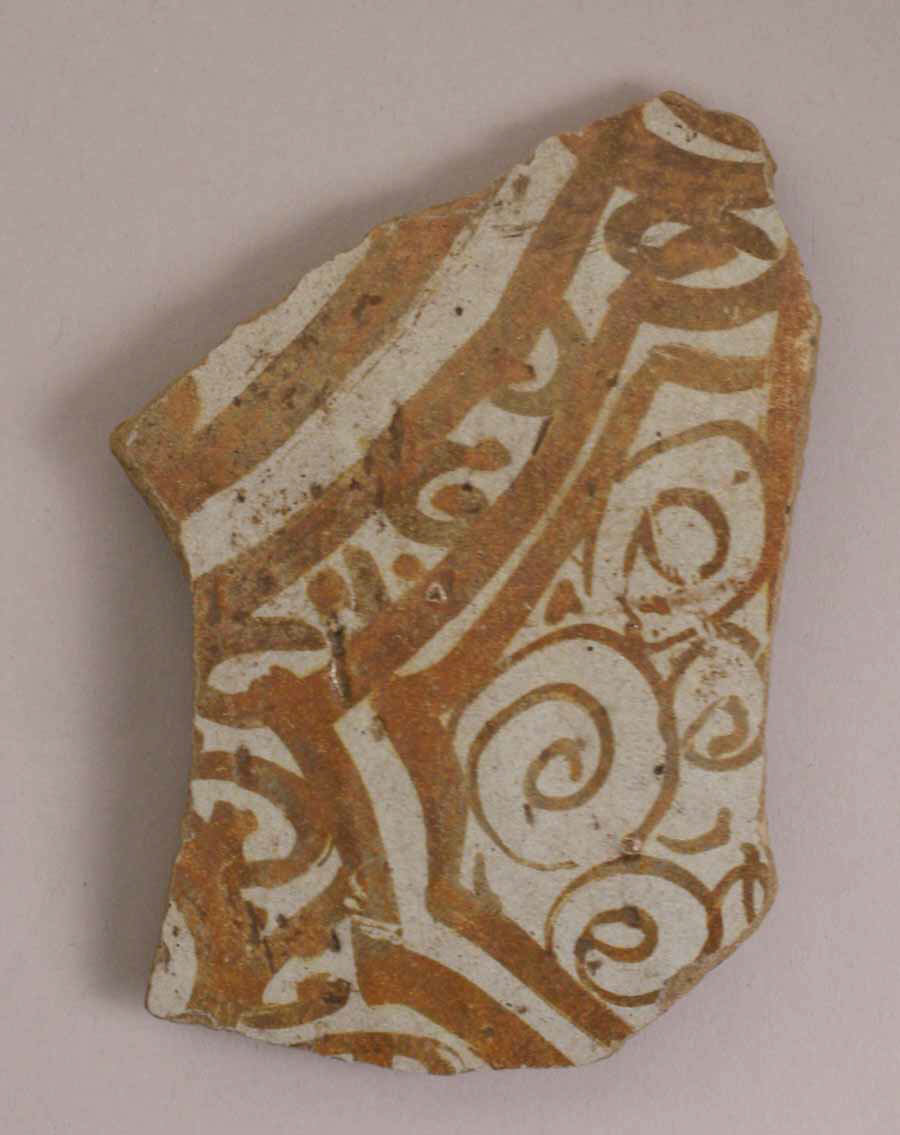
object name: ceramic fragment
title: Fragment of a Dish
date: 1001-1200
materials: pottery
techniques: luster painting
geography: egypt